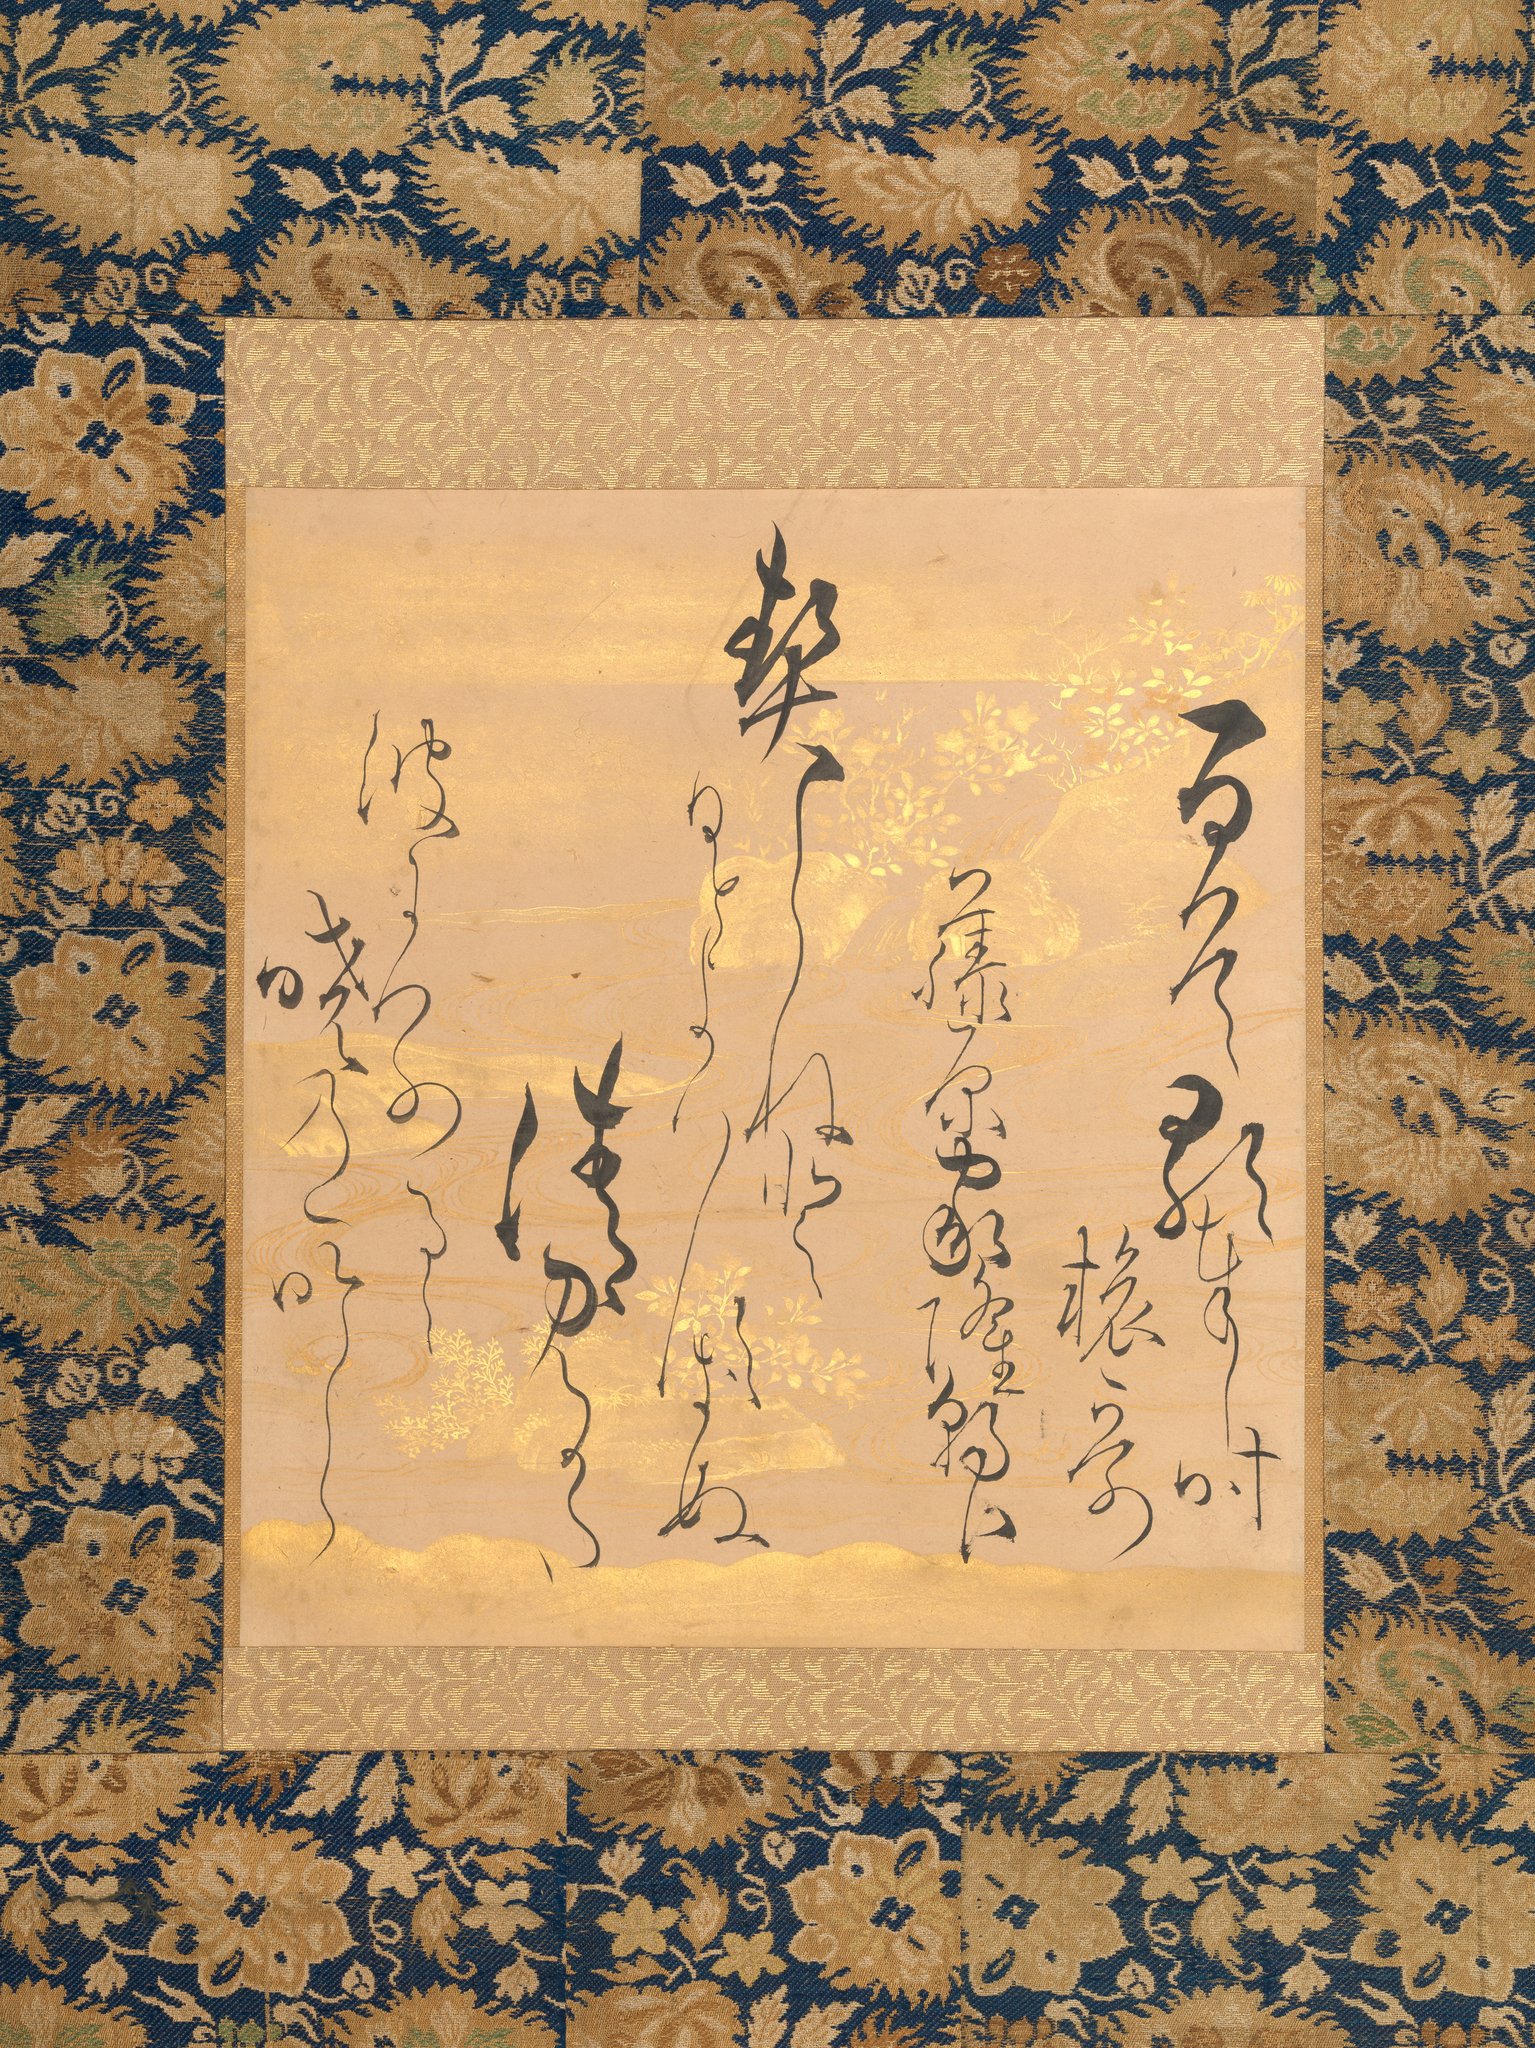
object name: hanging scroll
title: Poem by Fujiwara no Ietaka (1158–1237) on Decorated Paper with Bush Clover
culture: japanese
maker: ogata sōken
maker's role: artist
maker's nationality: japanese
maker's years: 1621-1687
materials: gold, ink, paper